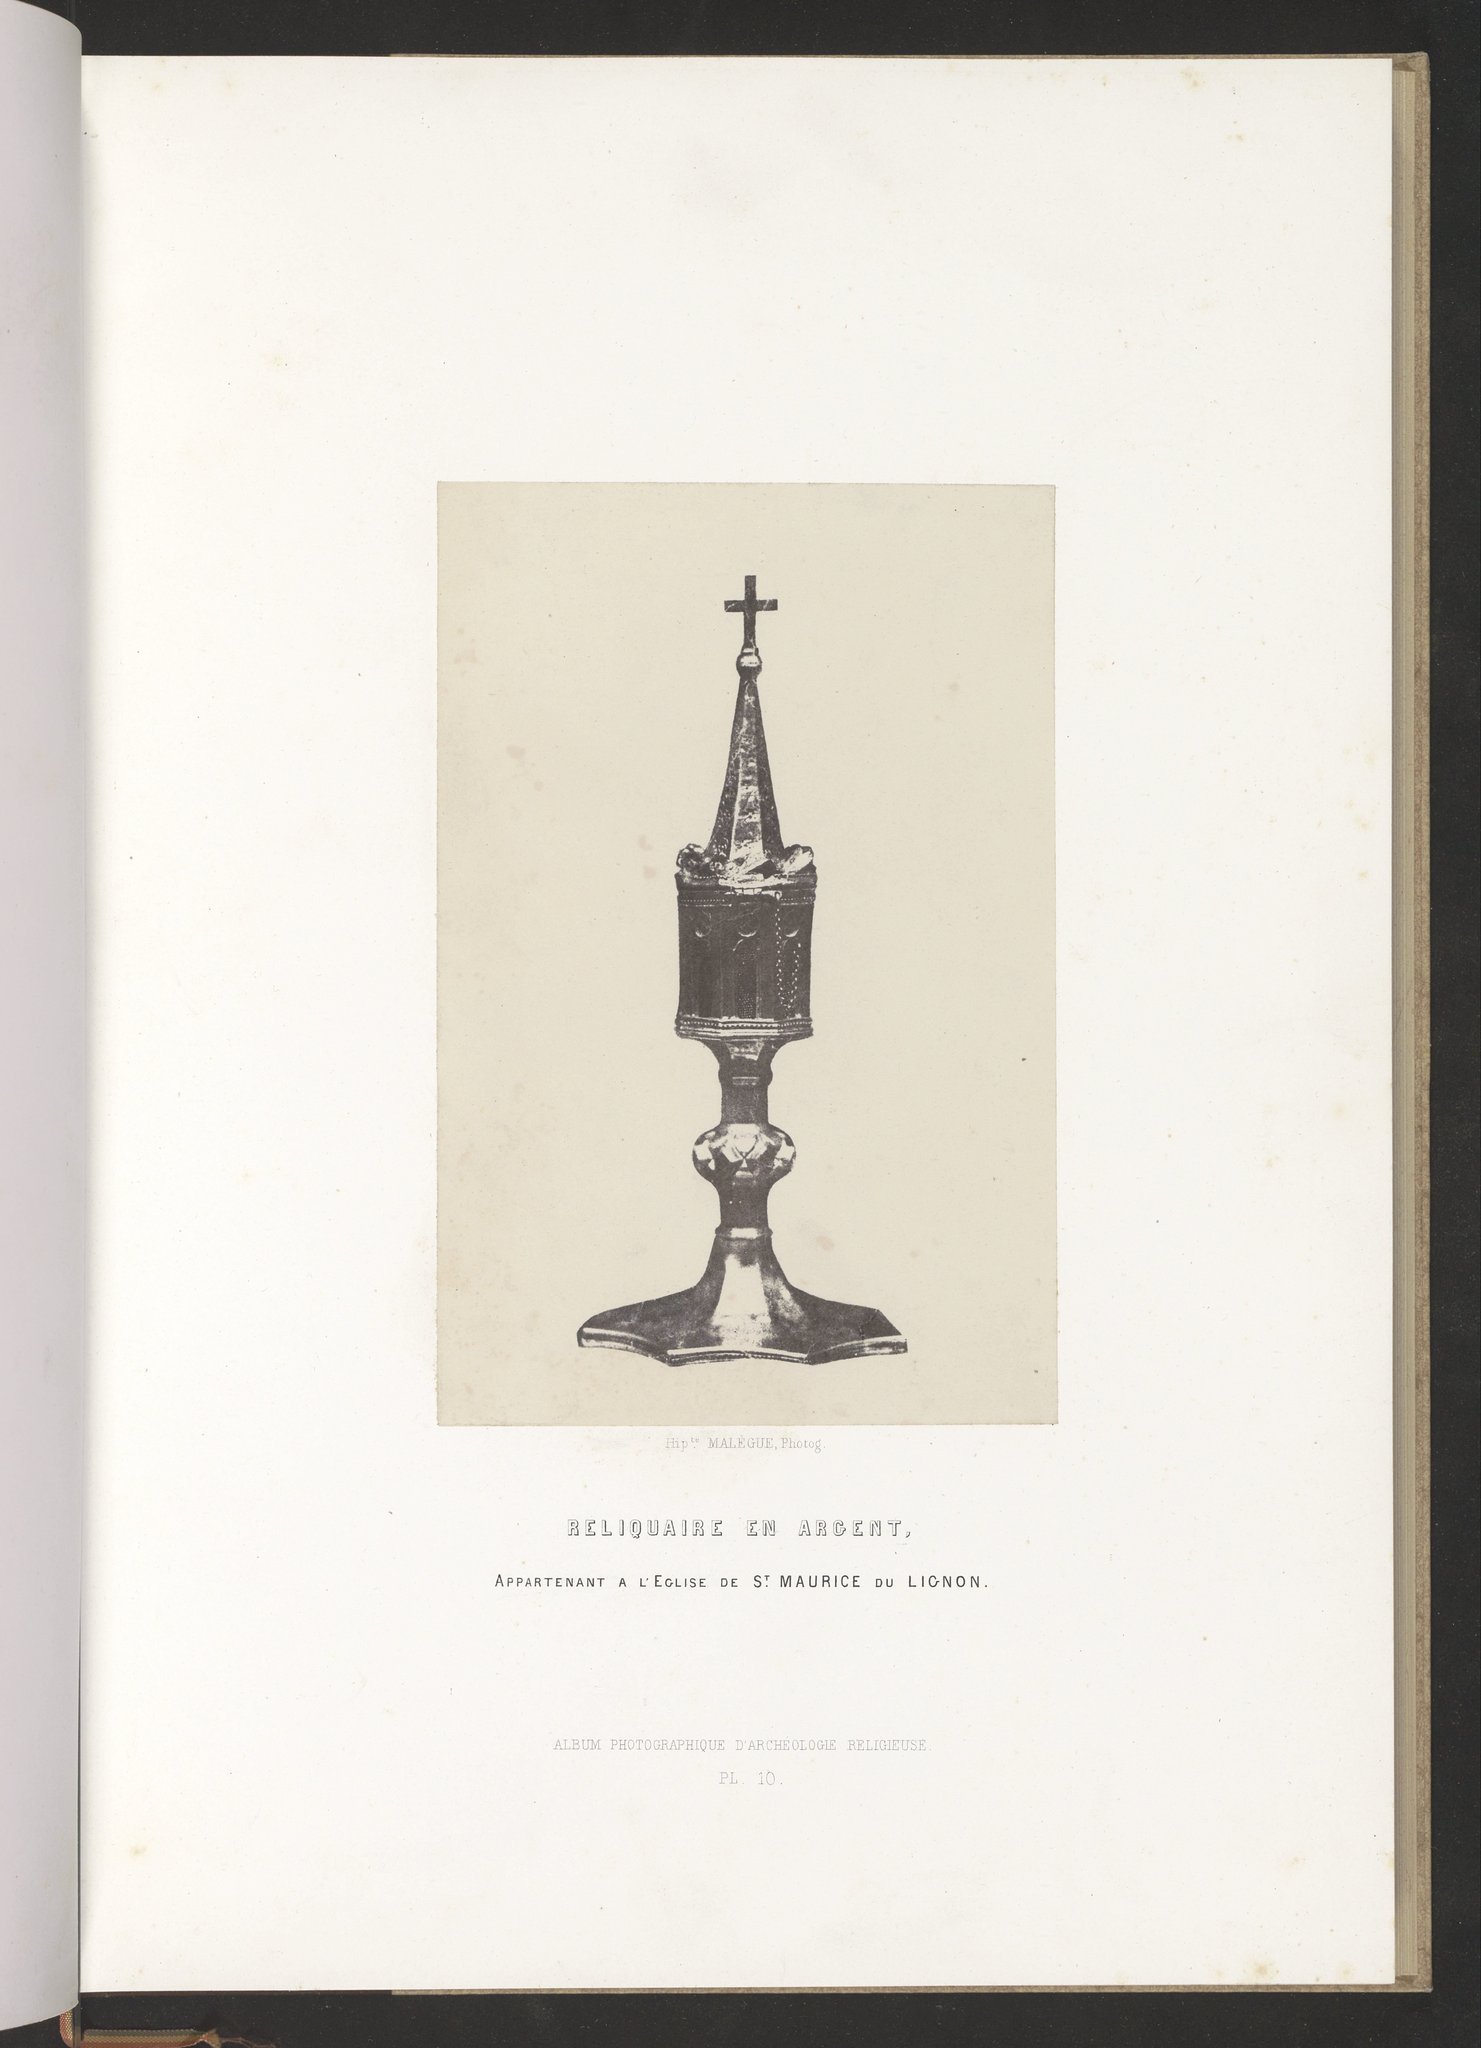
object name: page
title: Zilveren reliekhouder afkomstig uit de kerk Saint-Maurice te Saint-Maurice-de-Lignon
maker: hippolyte malègue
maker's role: archeoloog, fotograaf, schrijver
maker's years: 1825-1901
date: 1850-1857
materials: photographic support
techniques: salted paper print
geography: france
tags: relics (and reliquaries)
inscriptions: number: ‘PL. 10.’, inscription: ‘appartenant a l'eglise de St. Maurice du Lignon.’